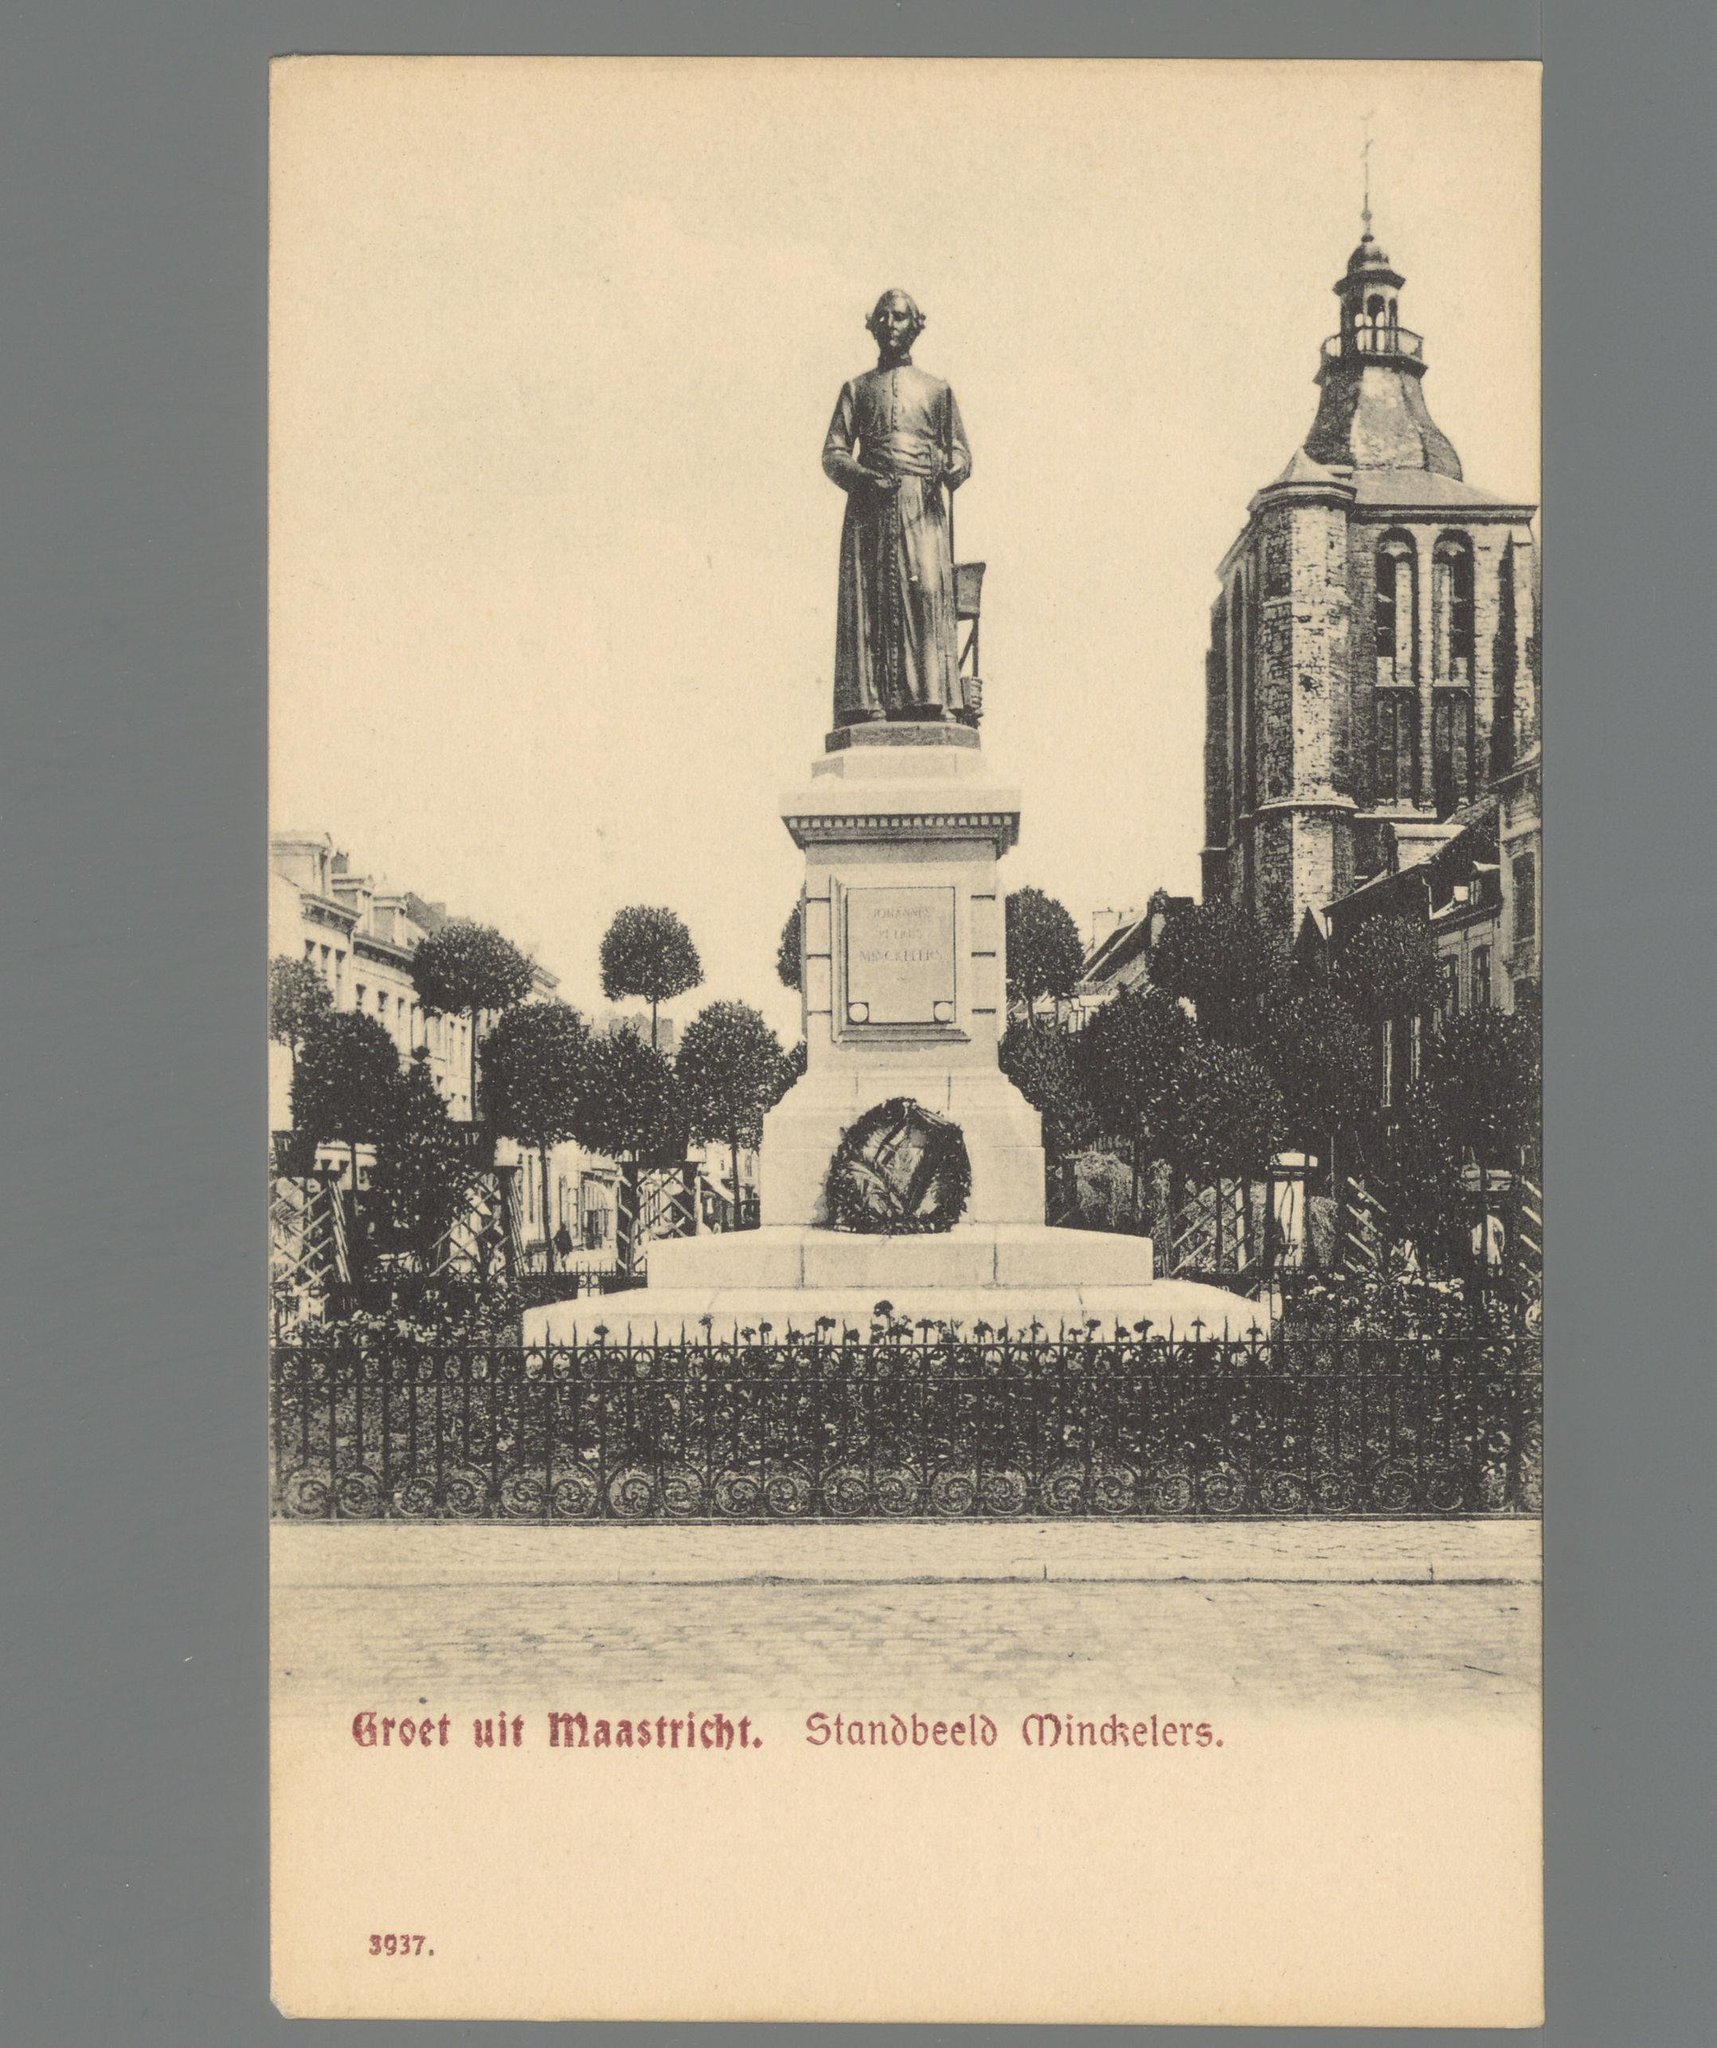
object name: photomechanical print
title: Groet uit Maastricht. Standbeeld Minckelers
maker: Anonymous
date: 1897-1905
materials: cardboard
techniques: photograph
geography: maastricht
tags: church (exterior), monument, statue